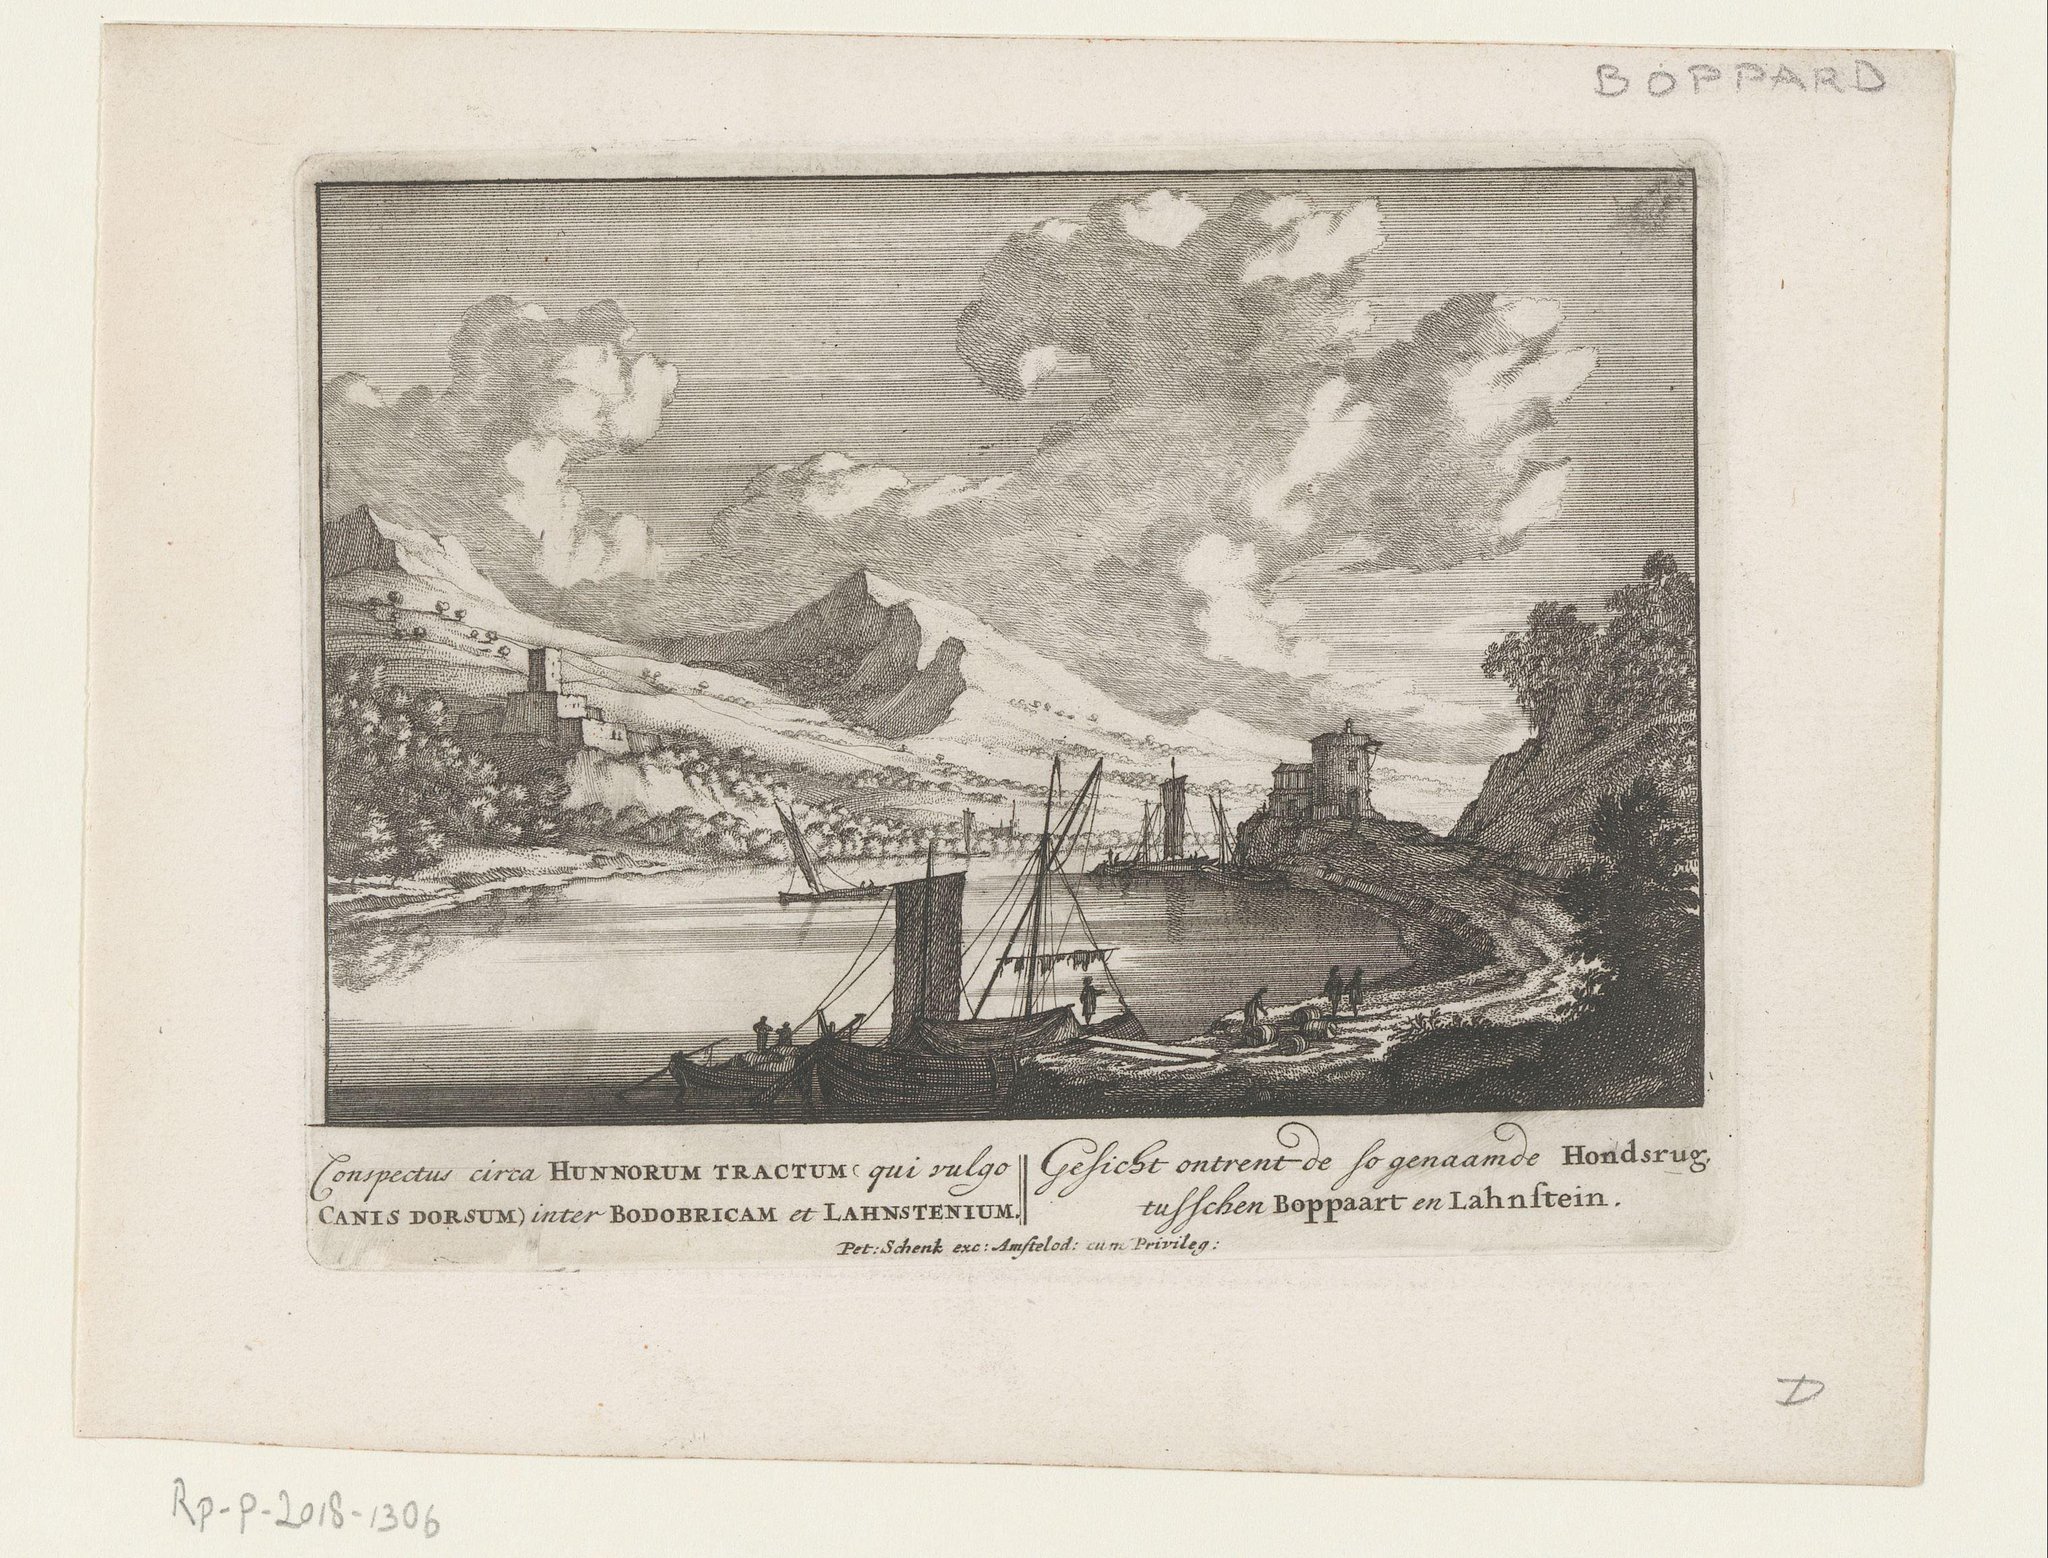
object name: print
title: Gezicht op de Hunsrück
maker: pieter schenk (i)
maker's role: print maker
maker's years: 1660-1711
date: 1694-1697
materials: paper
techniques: engraving, etching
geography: amsterdam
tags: low hill country, river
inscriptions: collector's mark: Lugt 2228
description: Prent ook gebruikt in: Admirandorum quadruplex spectaculum / delectum, pictum, et aeri in cisum, per Johannem van Call. Amsterdam: Pieter Schenk (I), ca. 1694-1697.